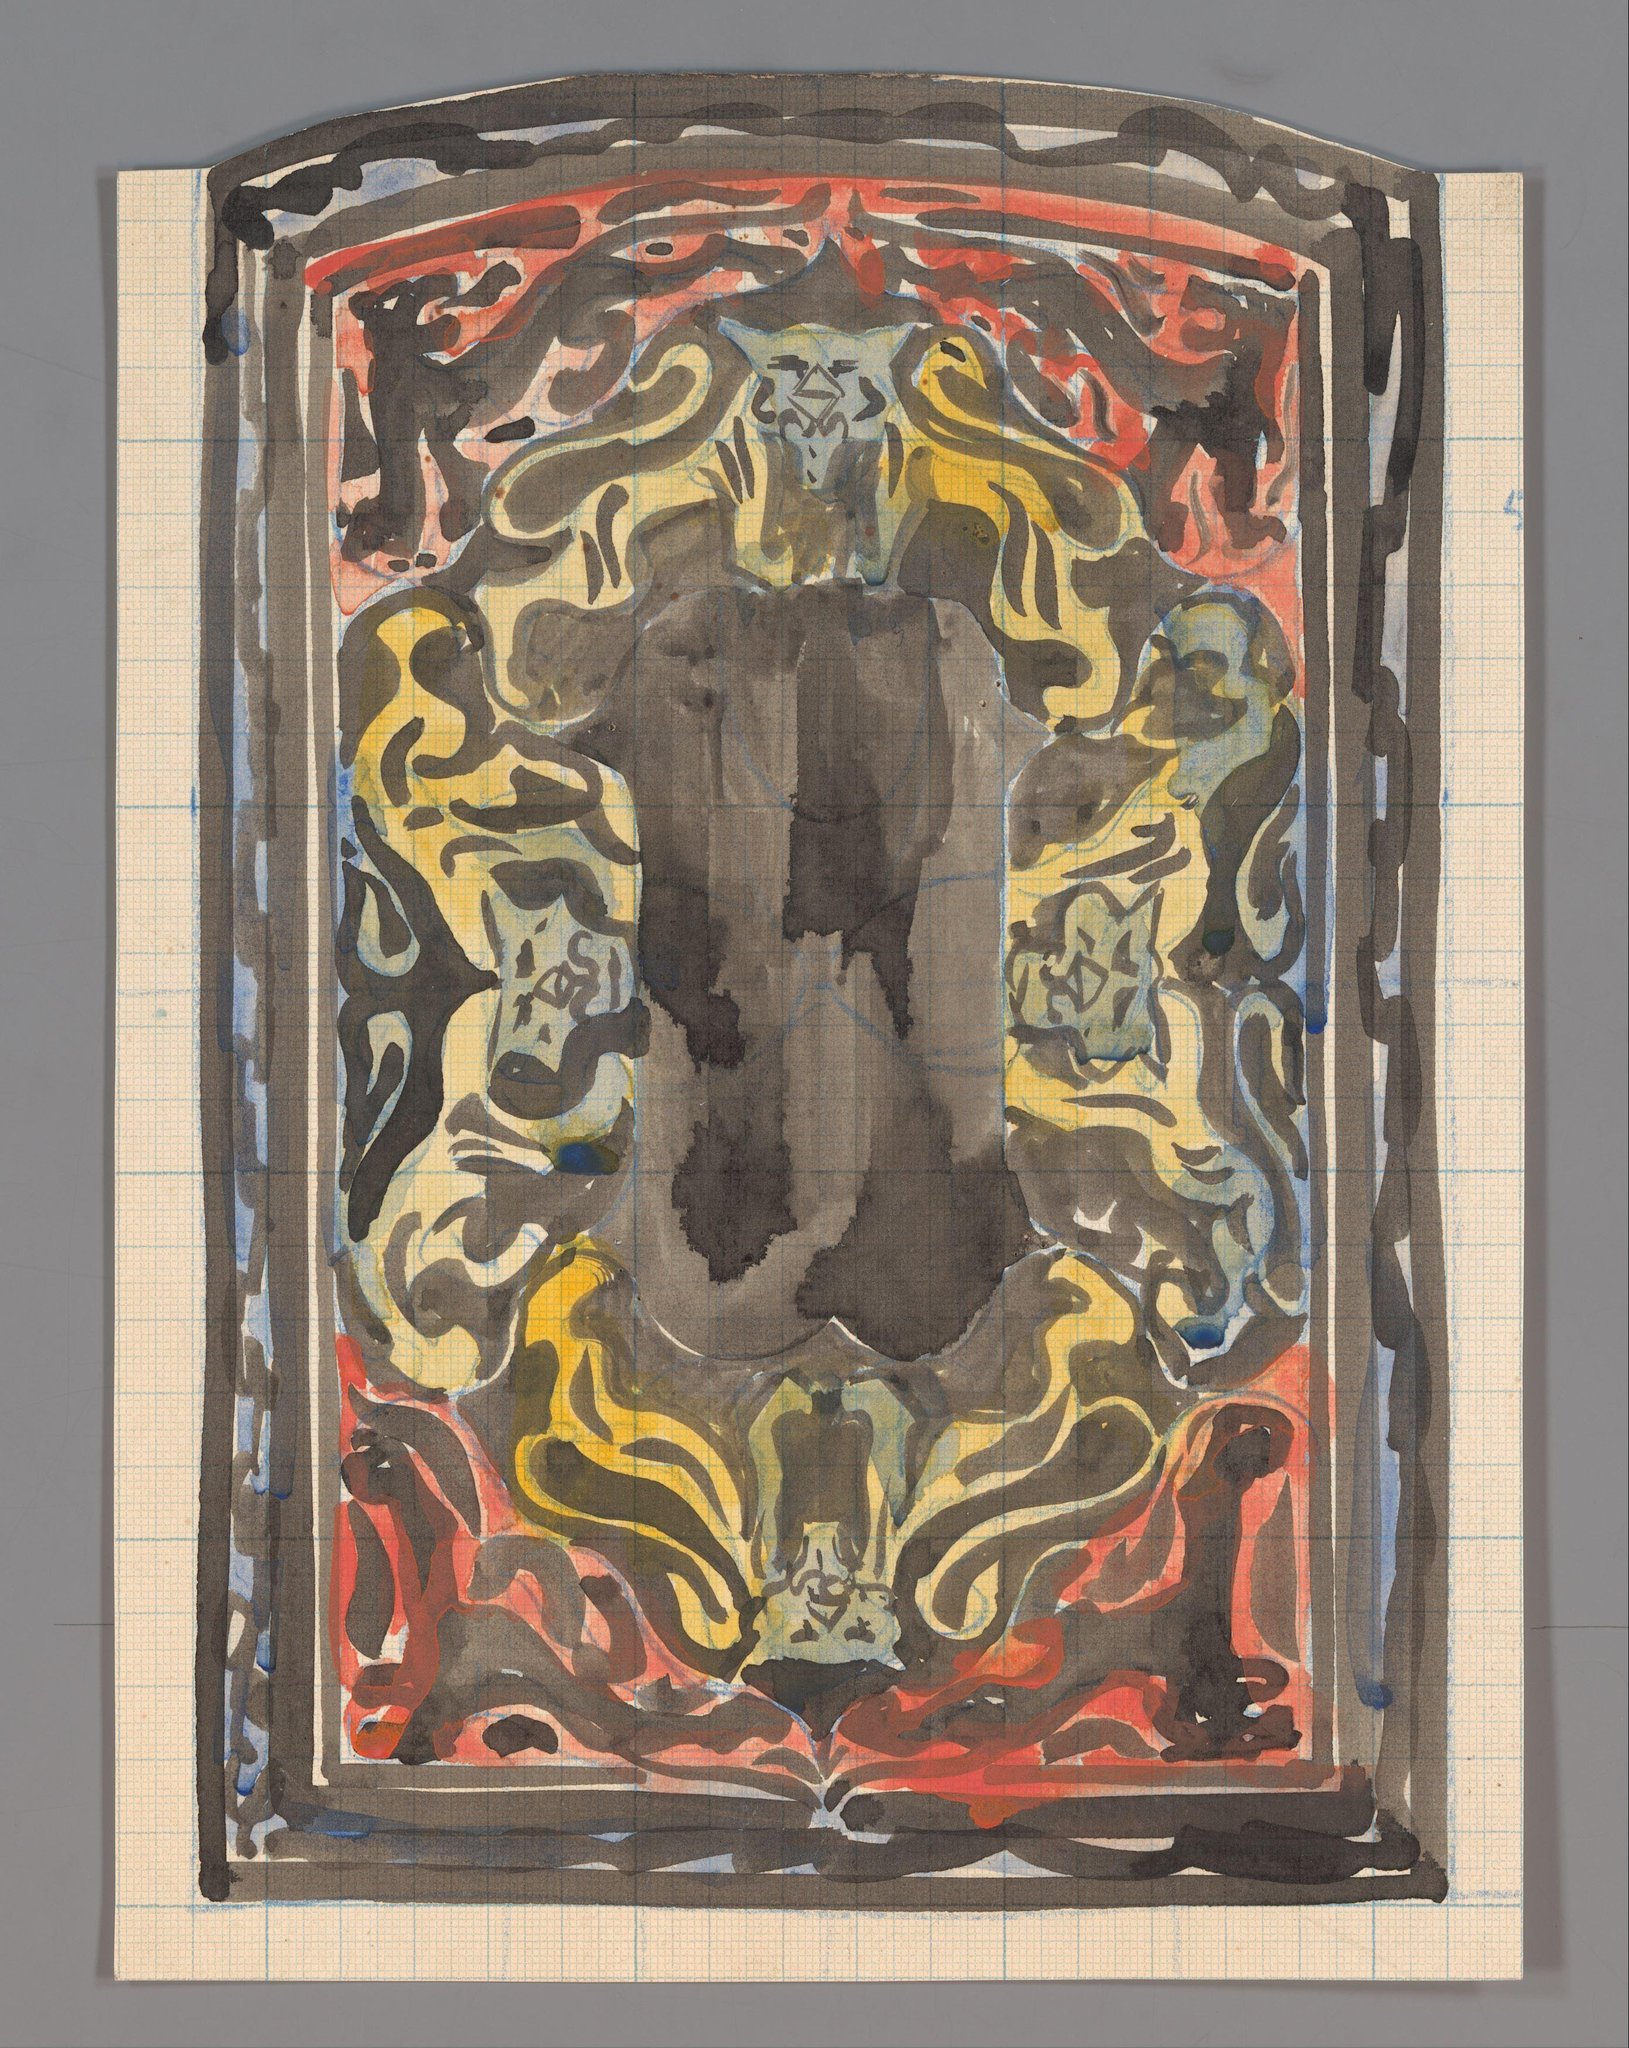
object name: design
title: Ontwerp voor een tegeltableau met leeuwen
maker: carel adolph lion cachet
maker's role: draughtsman, print maker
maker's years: 1864-1945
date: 1874-1945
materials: pencil, watercolor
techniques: brush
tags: ornament derived from animal forms, work of applied art (+ ceramics ~ arts), tiles, bricks ~ building material, wall-covering, beasts of prey, predatory animals: lion